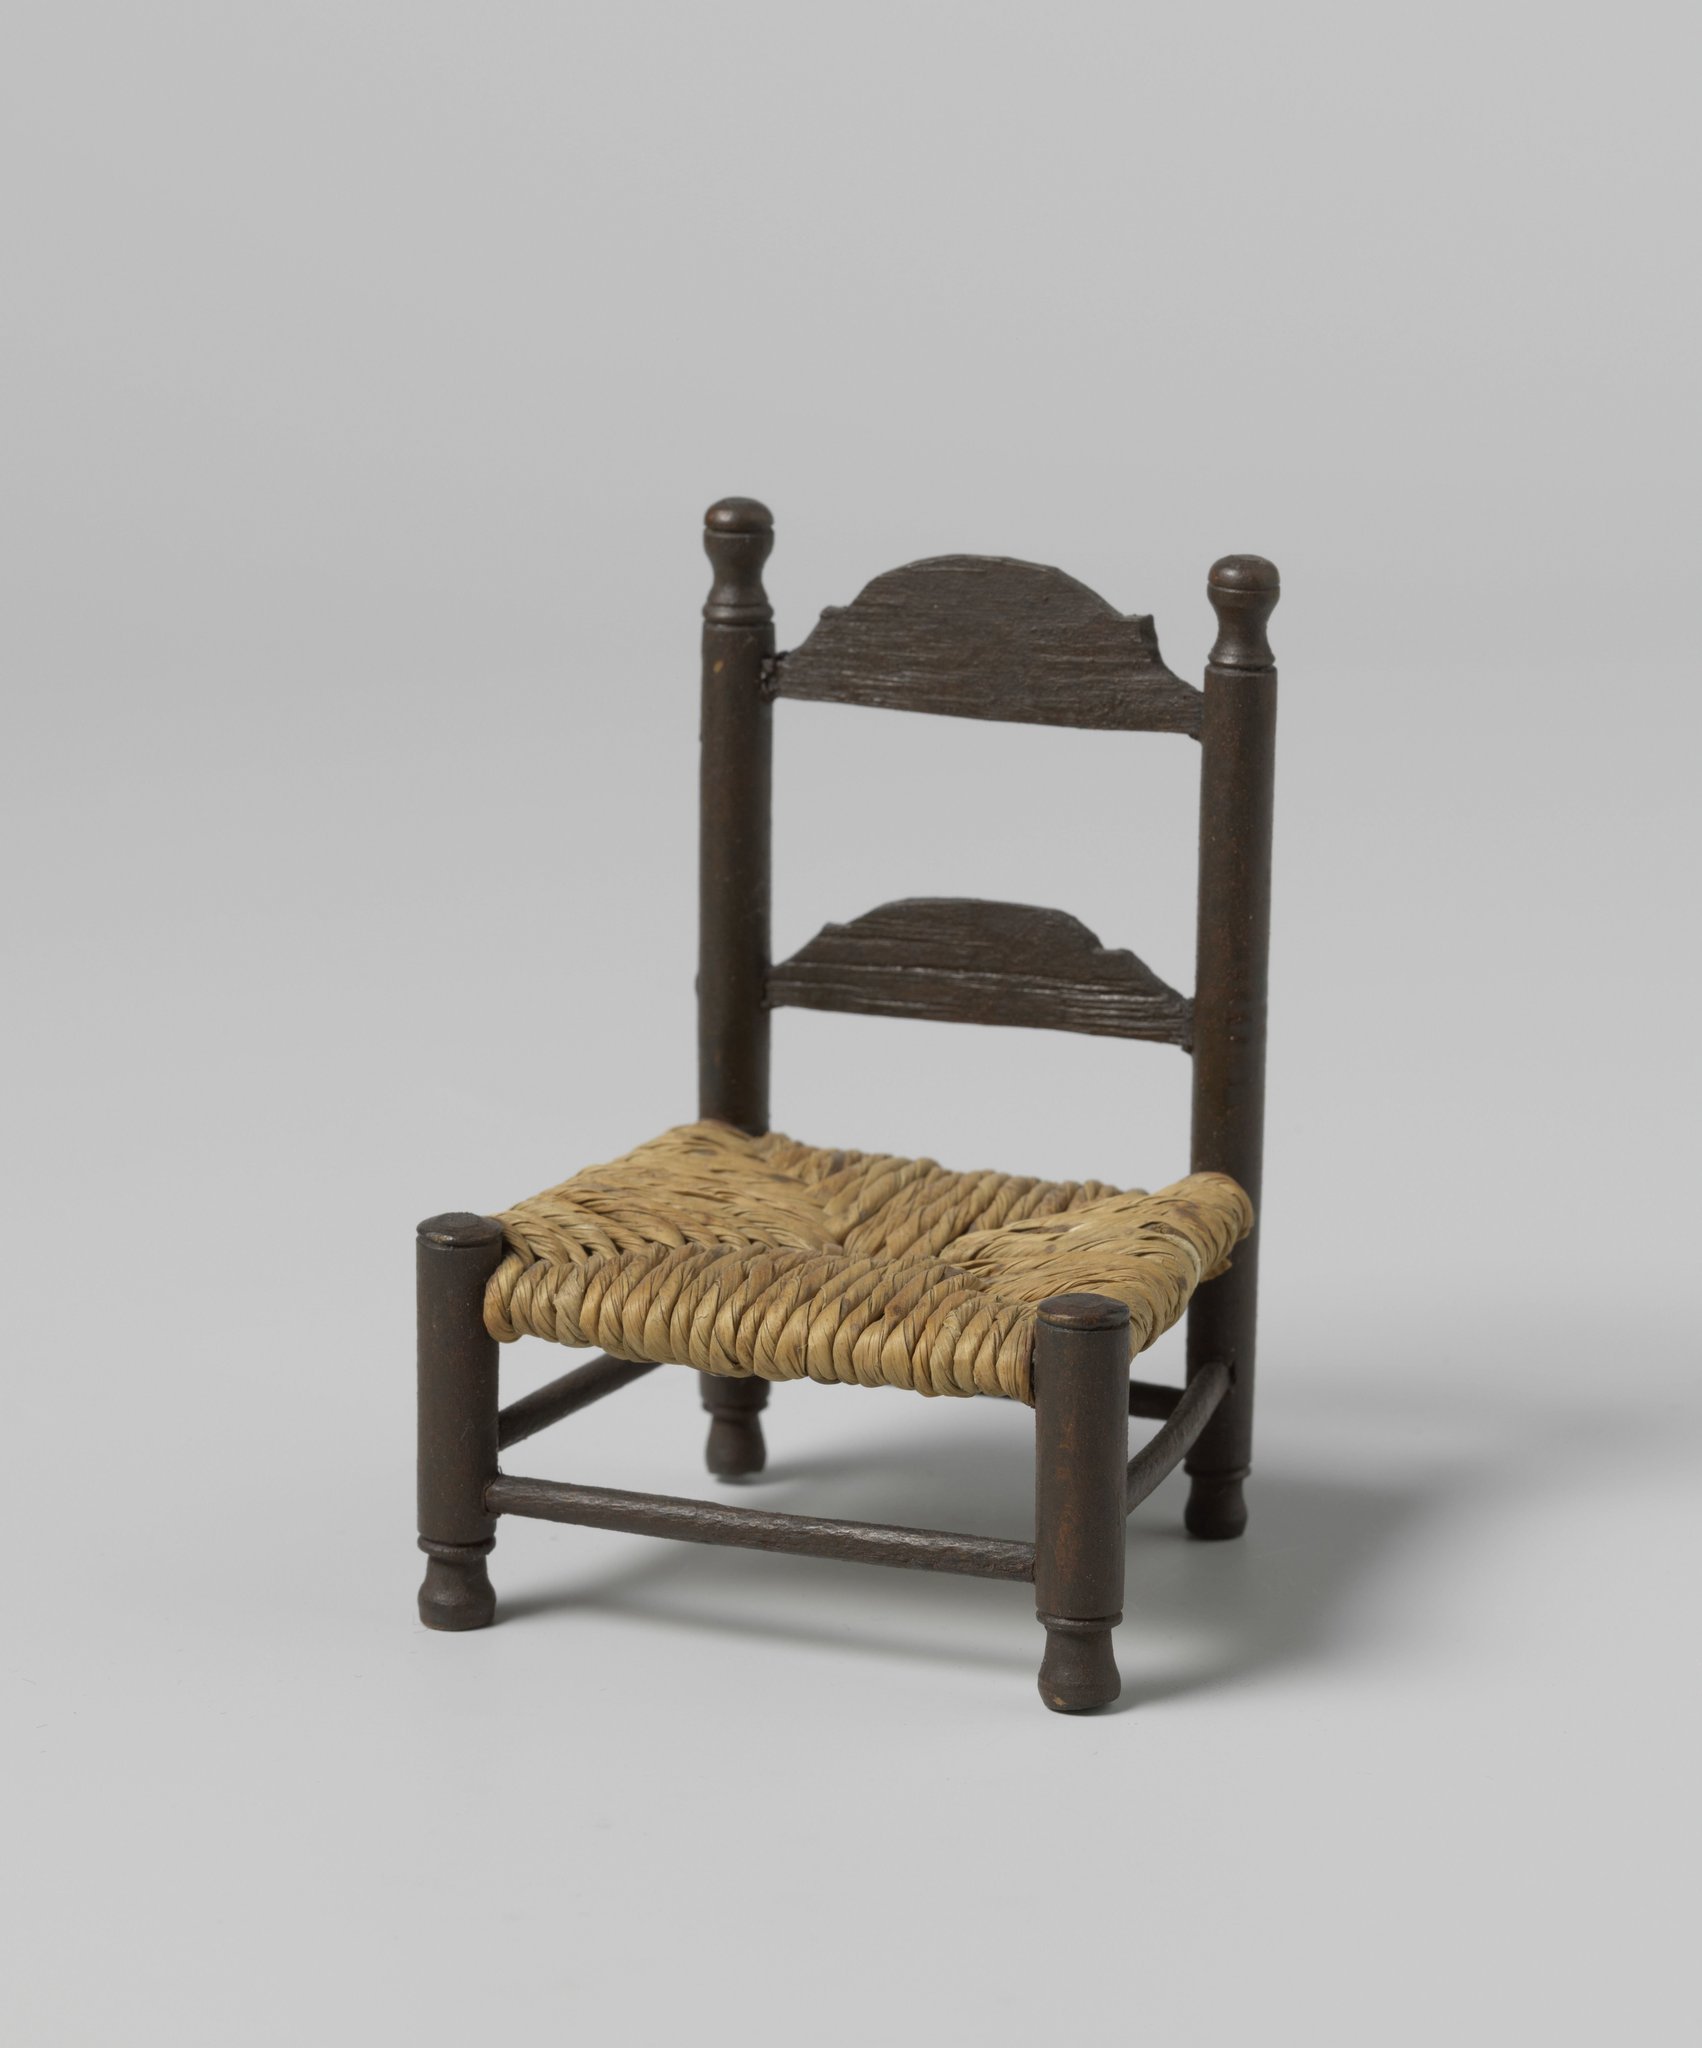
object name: miniature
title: Knopstoel, de rugleuning met twee dwarsregels, de zitting van gevlochten biezen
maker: Anonymous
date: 1750-1760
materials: fiber, wood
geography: amsterdam